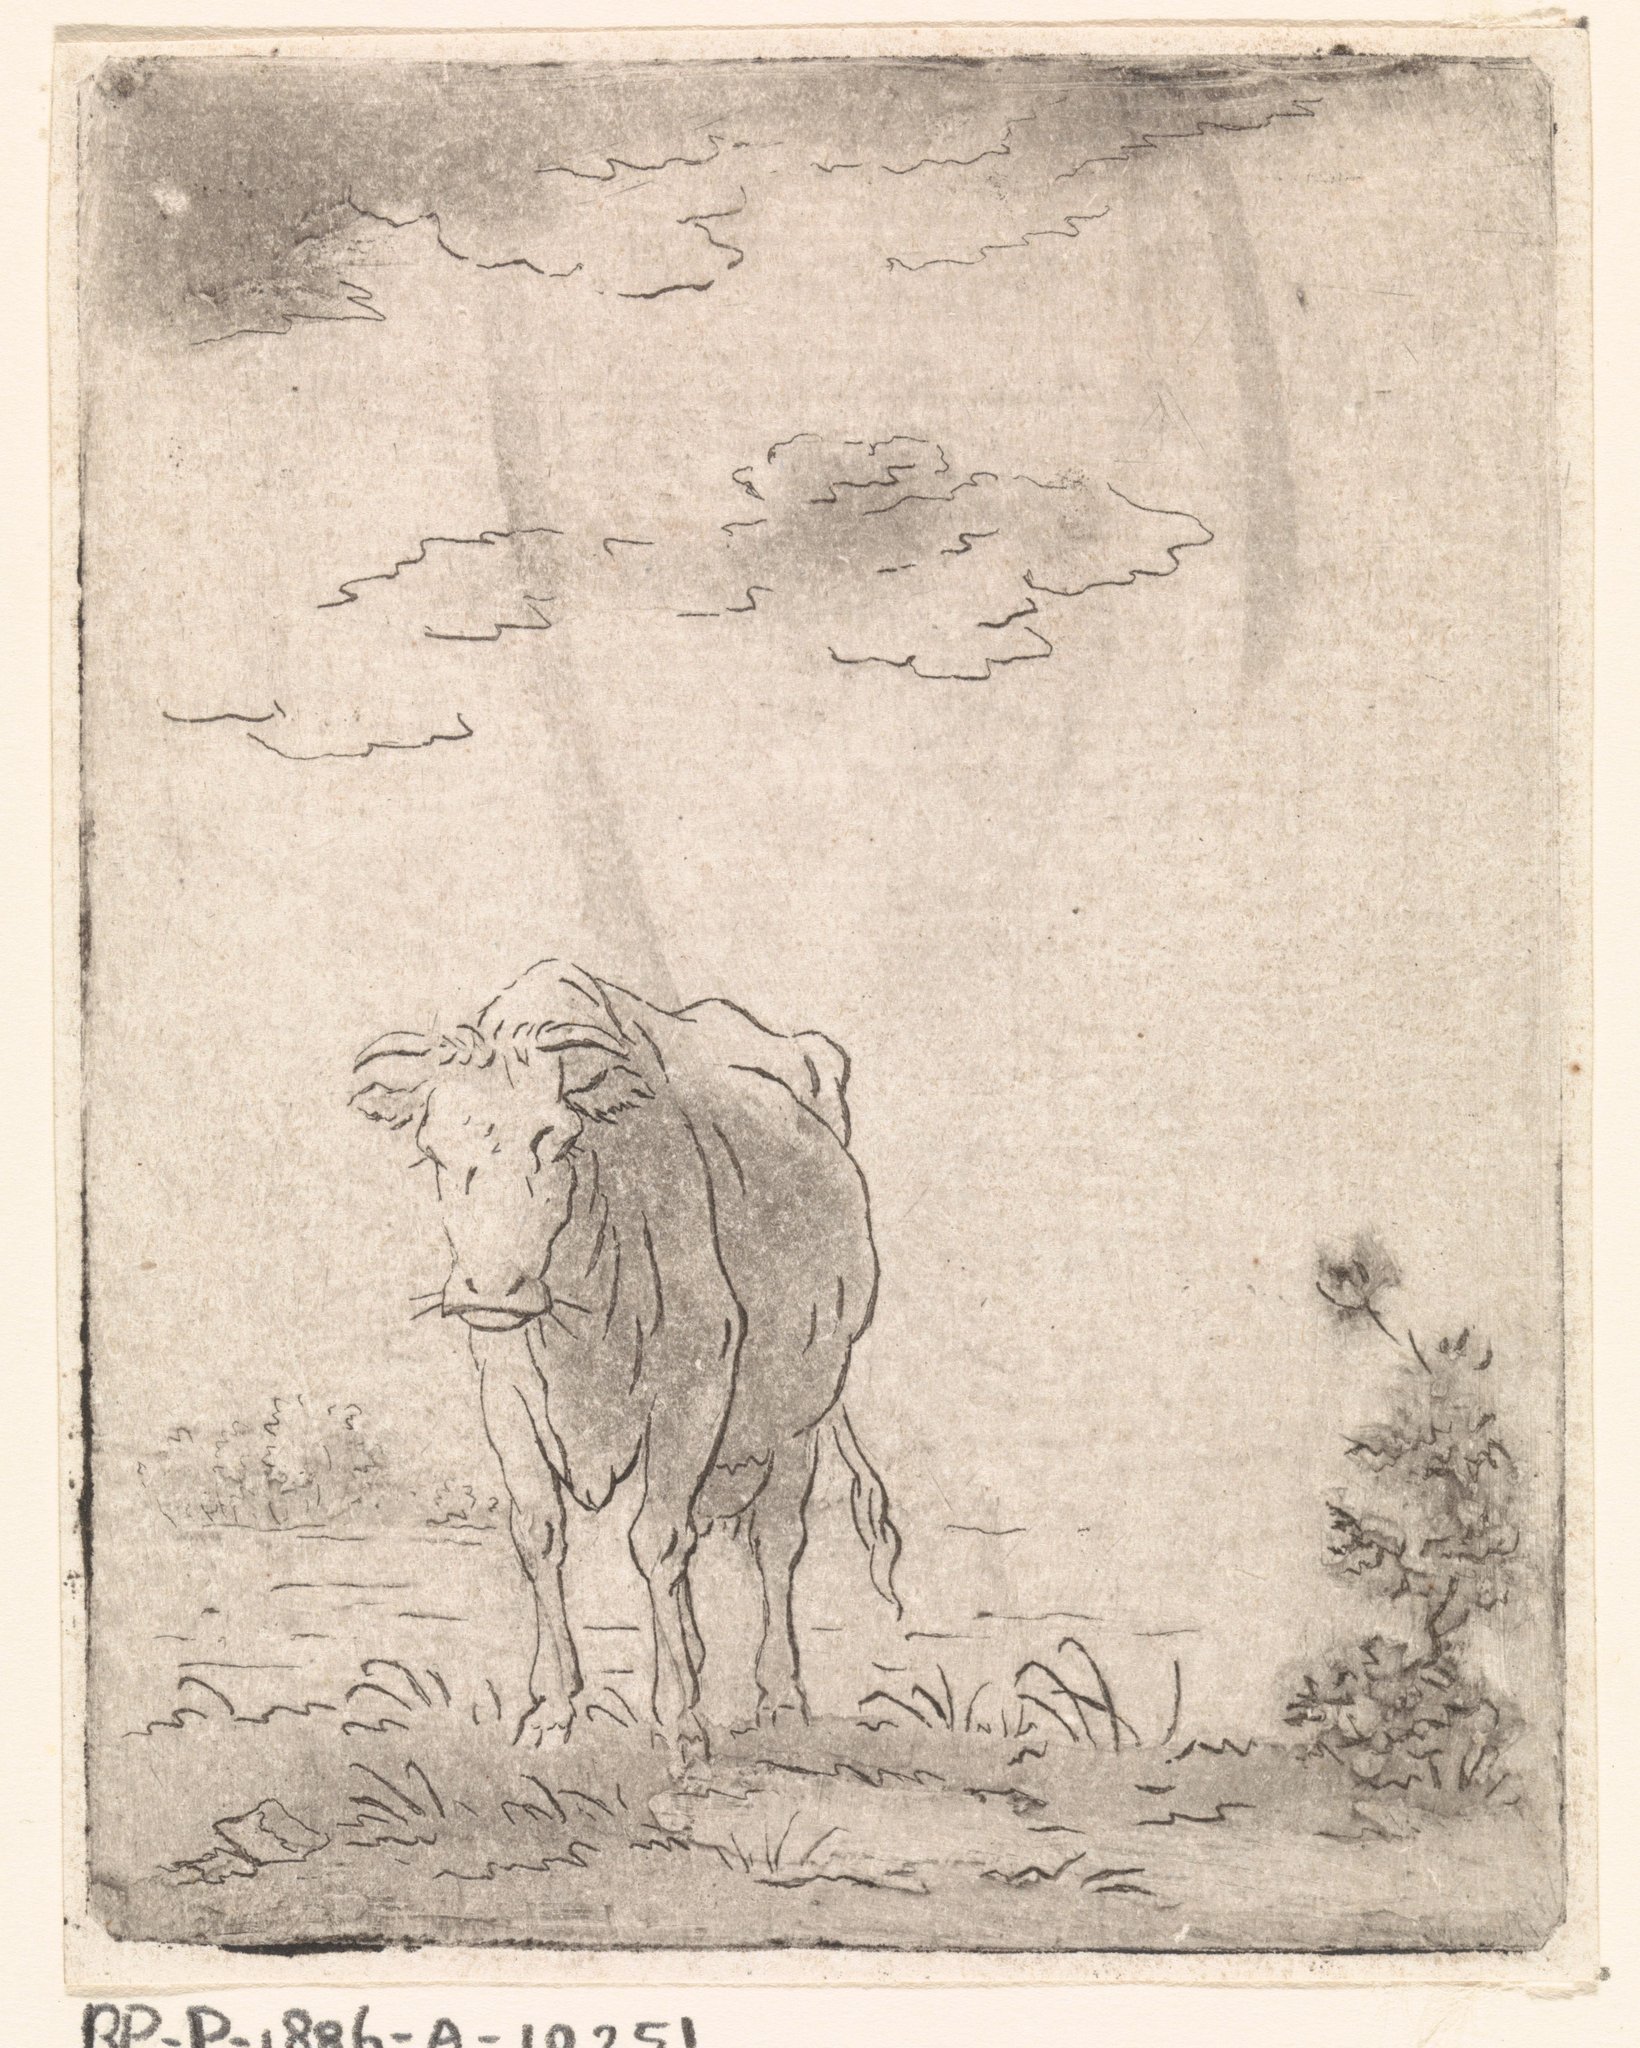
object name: print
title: Landschap met koe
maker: pieter janson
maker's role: draughtsman, print maker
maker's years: 1765-1851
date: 1780-1851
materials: chalk, paper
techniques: etching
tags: cow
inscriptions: collector's mark: Lugt 2228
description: Landschap met koe, van voren. Rechts op de voorgrond een struik.